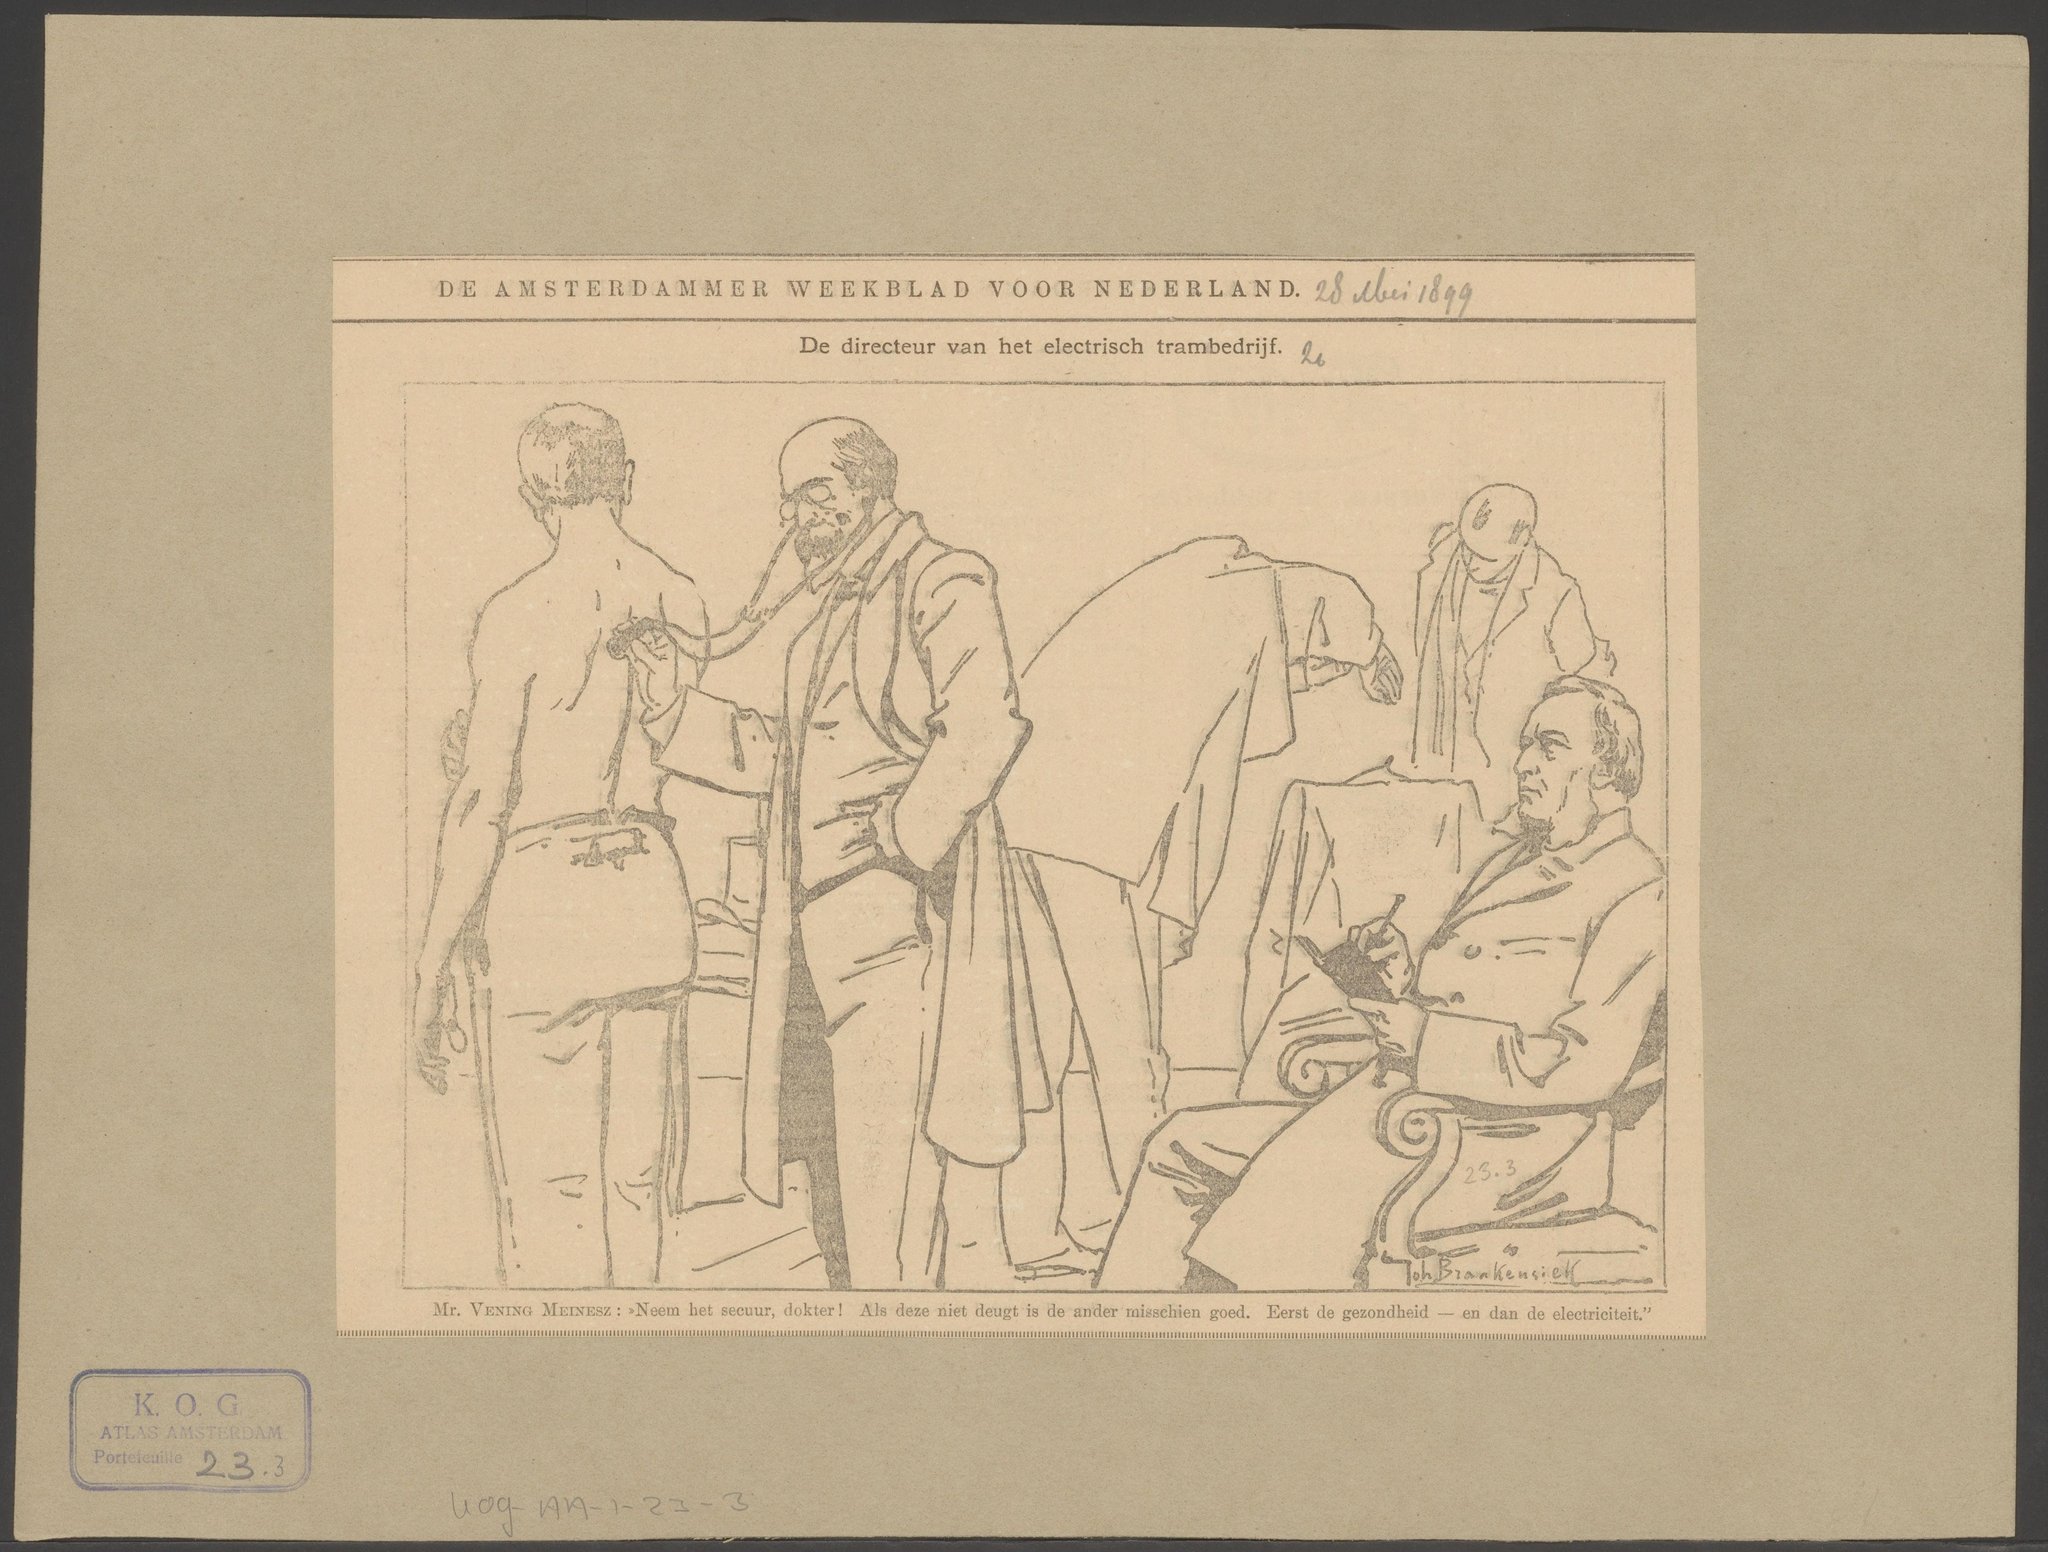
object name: photomechanical print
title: De directeur van het electrisch trambedrijf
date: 1899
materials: paper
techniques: letterpress printing, line block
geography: netherlands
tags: politician, tram, physician, doctor, political caricatures and satires, amsterdam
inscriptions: collector's mark: Lugt 1641b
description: Prent uit: De Amsterdammer 23 (1899), nr. 1144, 28 mei 1899, p. 7.